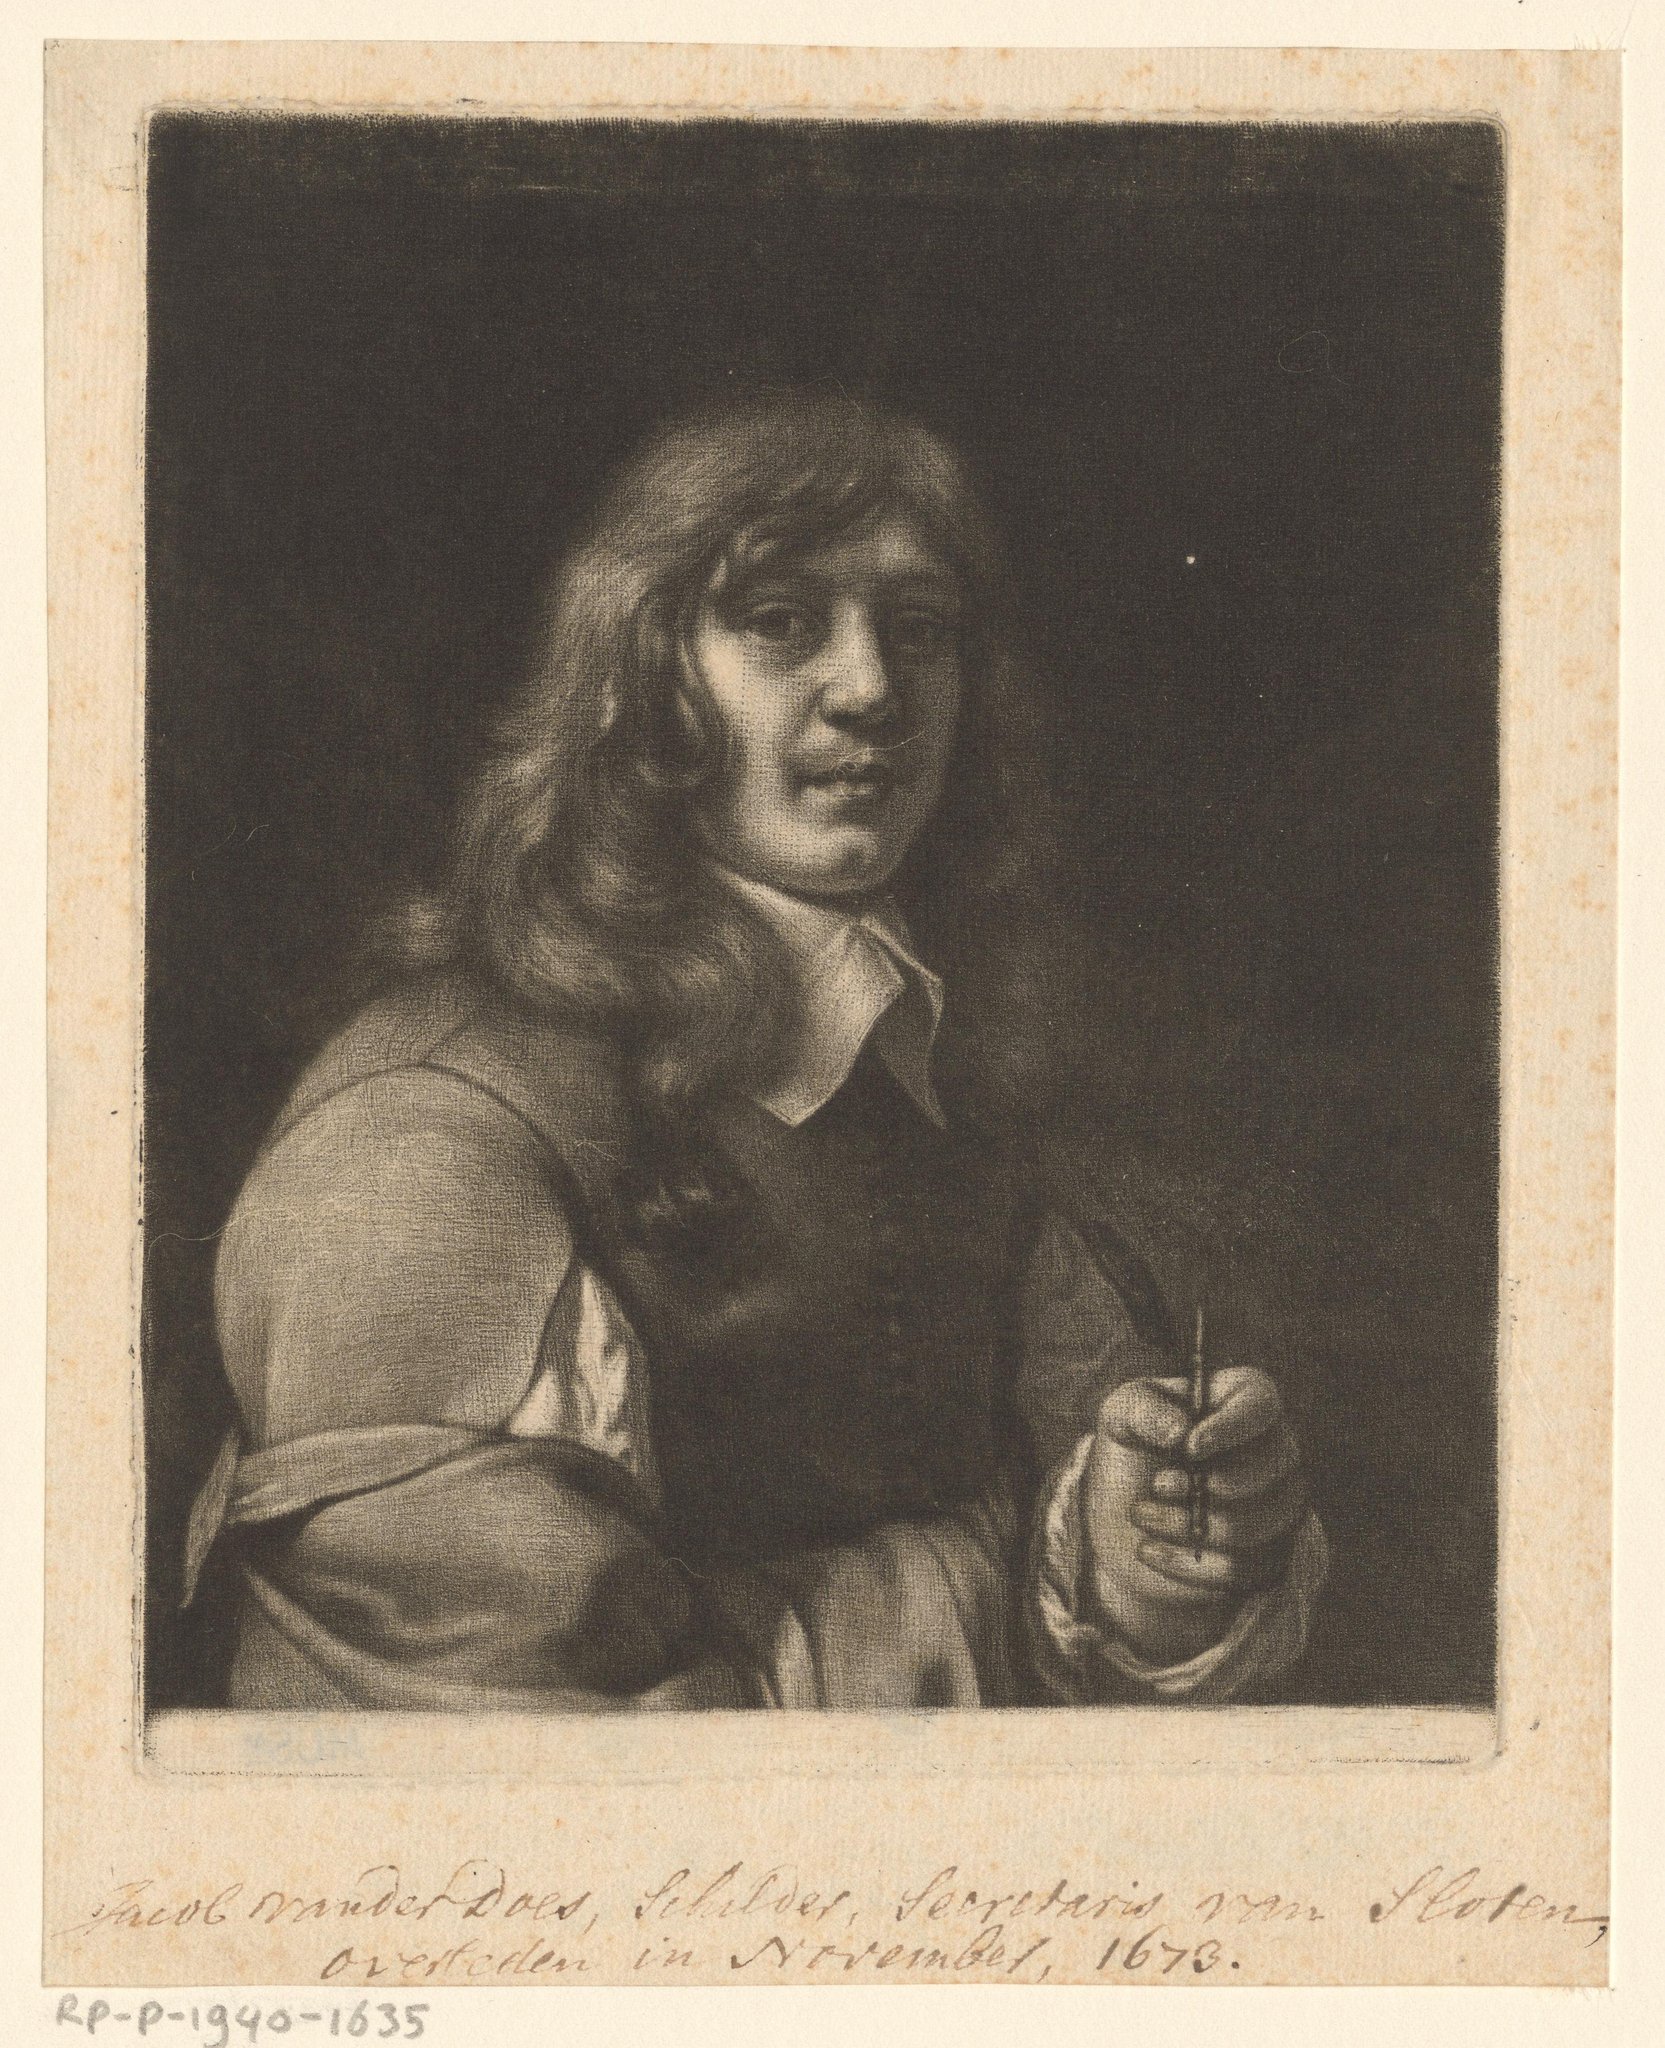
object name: print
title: Portret van Jacob van der Does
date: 1642-1677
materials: paper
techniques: mezzotint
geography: amsterdam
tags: amsterdam, painter, print maker, draughtsman, jacob van der does (i), historical persons, portrait, self-portrait of painter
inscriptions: inscription: ‘Jacob van der Does, schilder, secretaris van Sloten,/ overleden in november, 1673.’, collector's mark: Lugt 2166, collector's mark: Lugt 2760, collector's mark: Lugt 2228